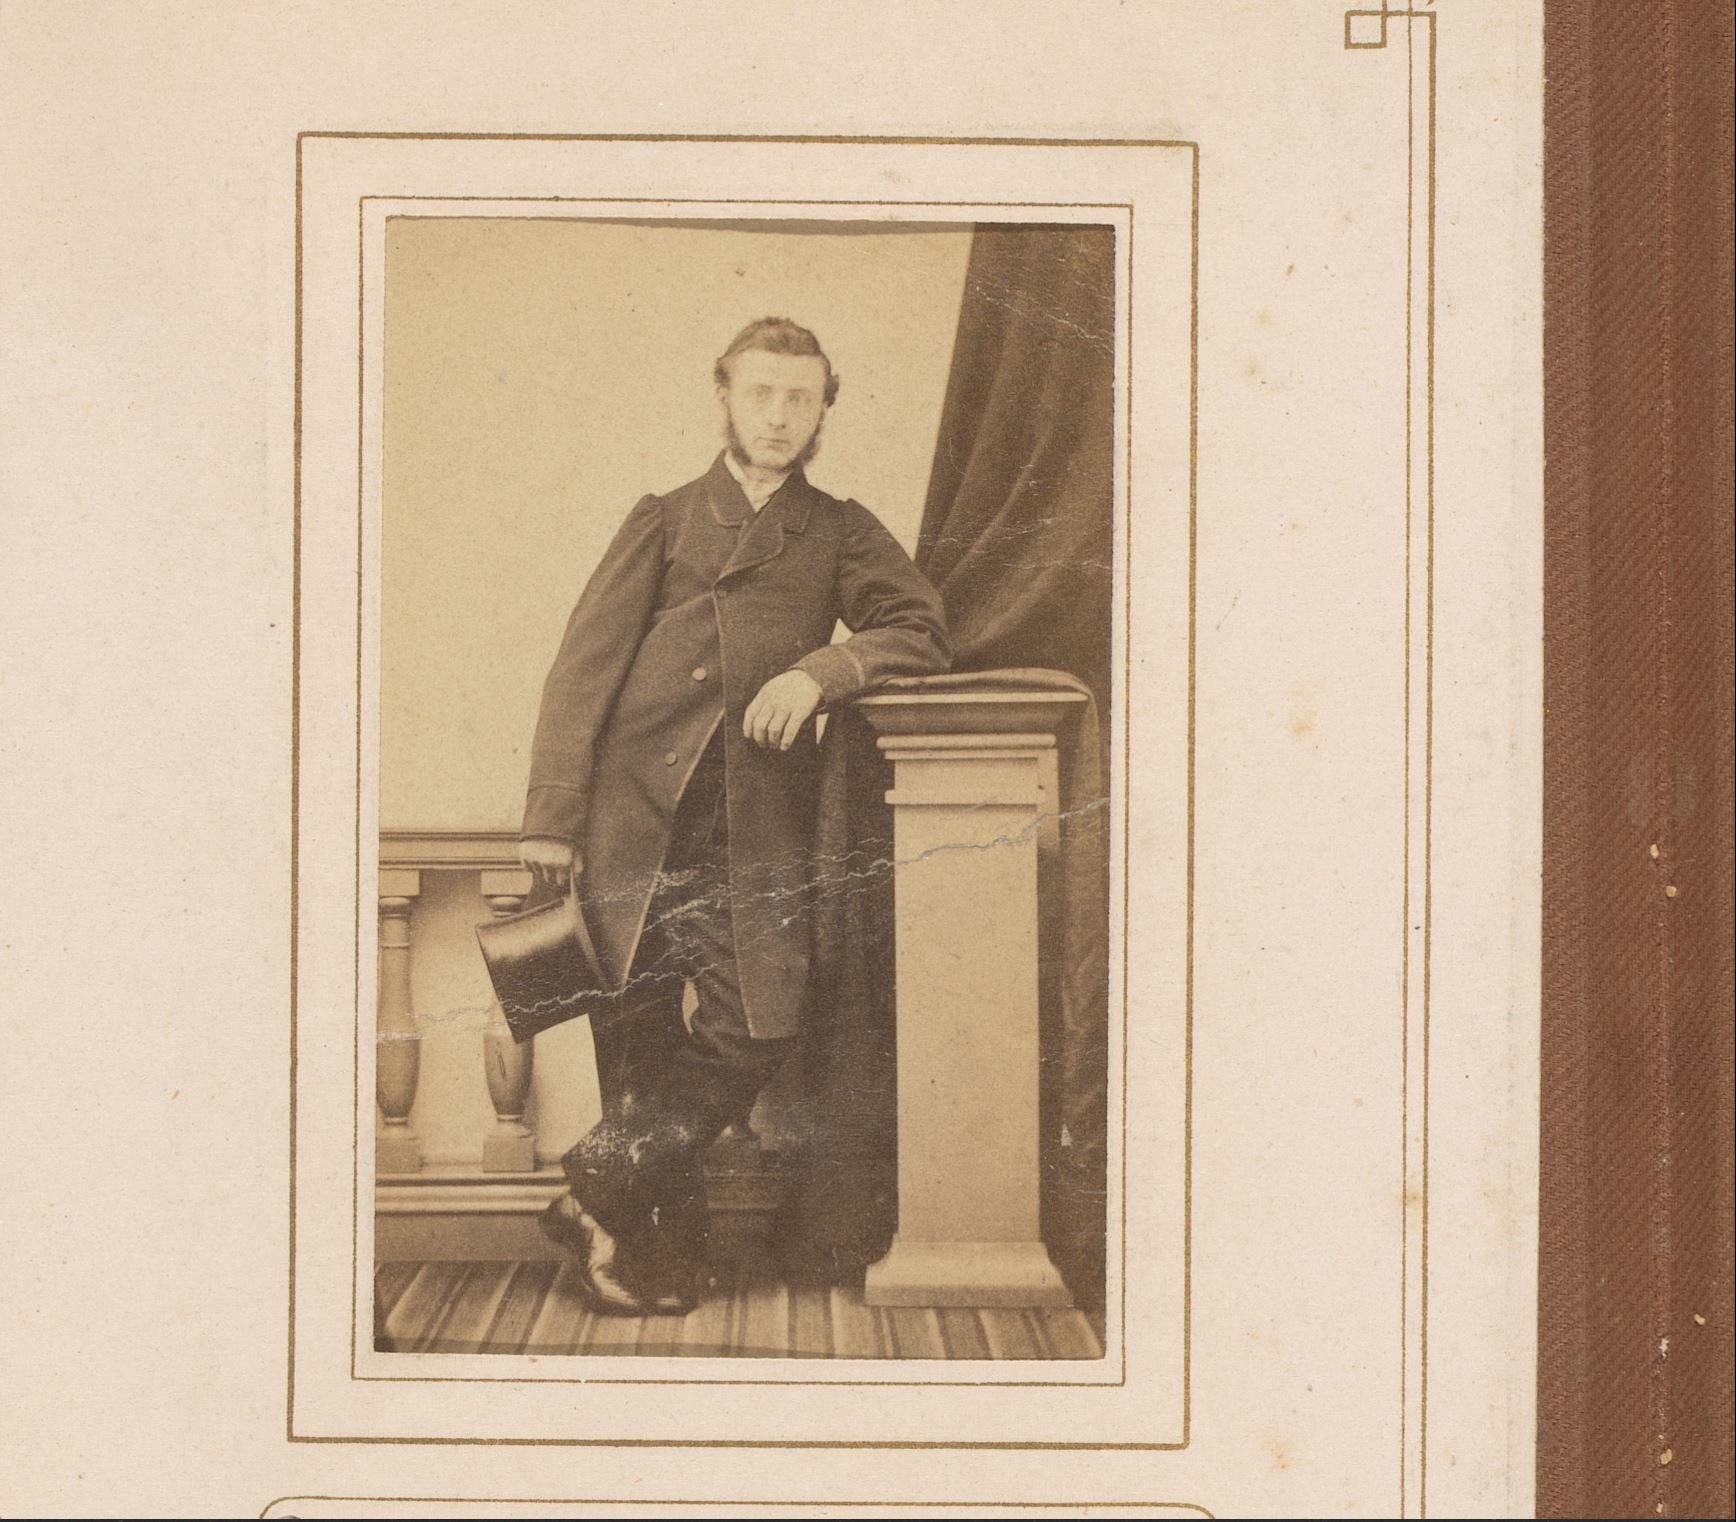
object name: photograph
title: Portret van een man met bakkebaarden en hoge hoed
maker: johan christiaan reesinck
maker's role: fotograaf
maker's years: 1838-1922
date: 1863-1900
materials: cardboard, photographic support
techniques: albumen print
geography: netherlands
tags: sideburns, historical persons, head-gear: top hat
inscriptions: name: ‘Reesinck’